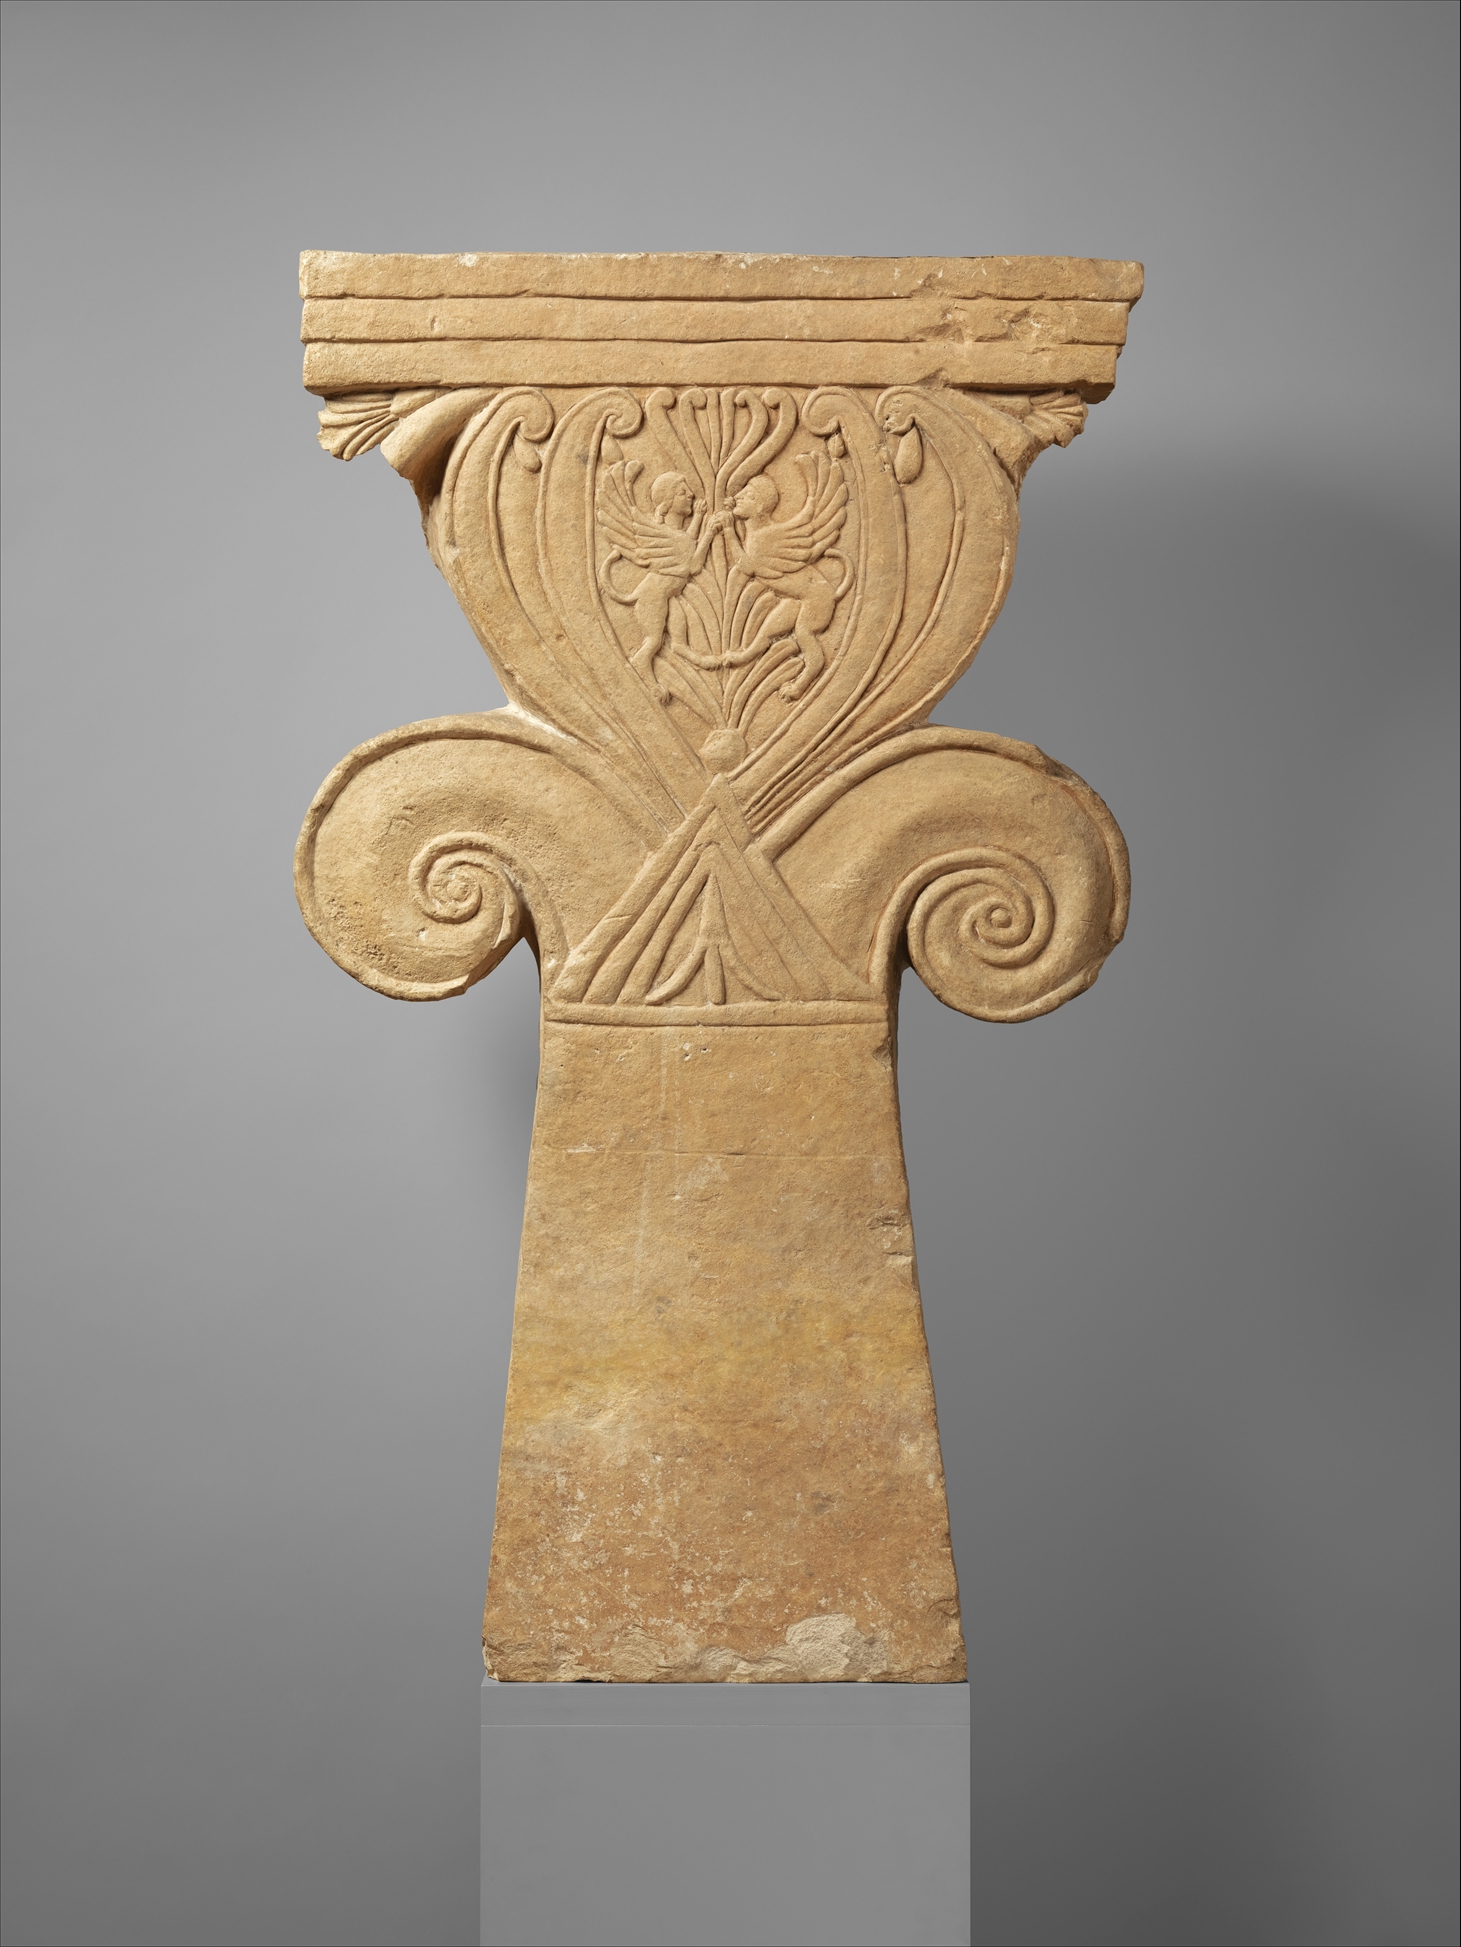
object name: grave stele with cypriot capital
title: Limestone funerary stele (shaft) with a "Cypriot capital"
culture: cypriot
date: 500-401 BCE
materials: limestone